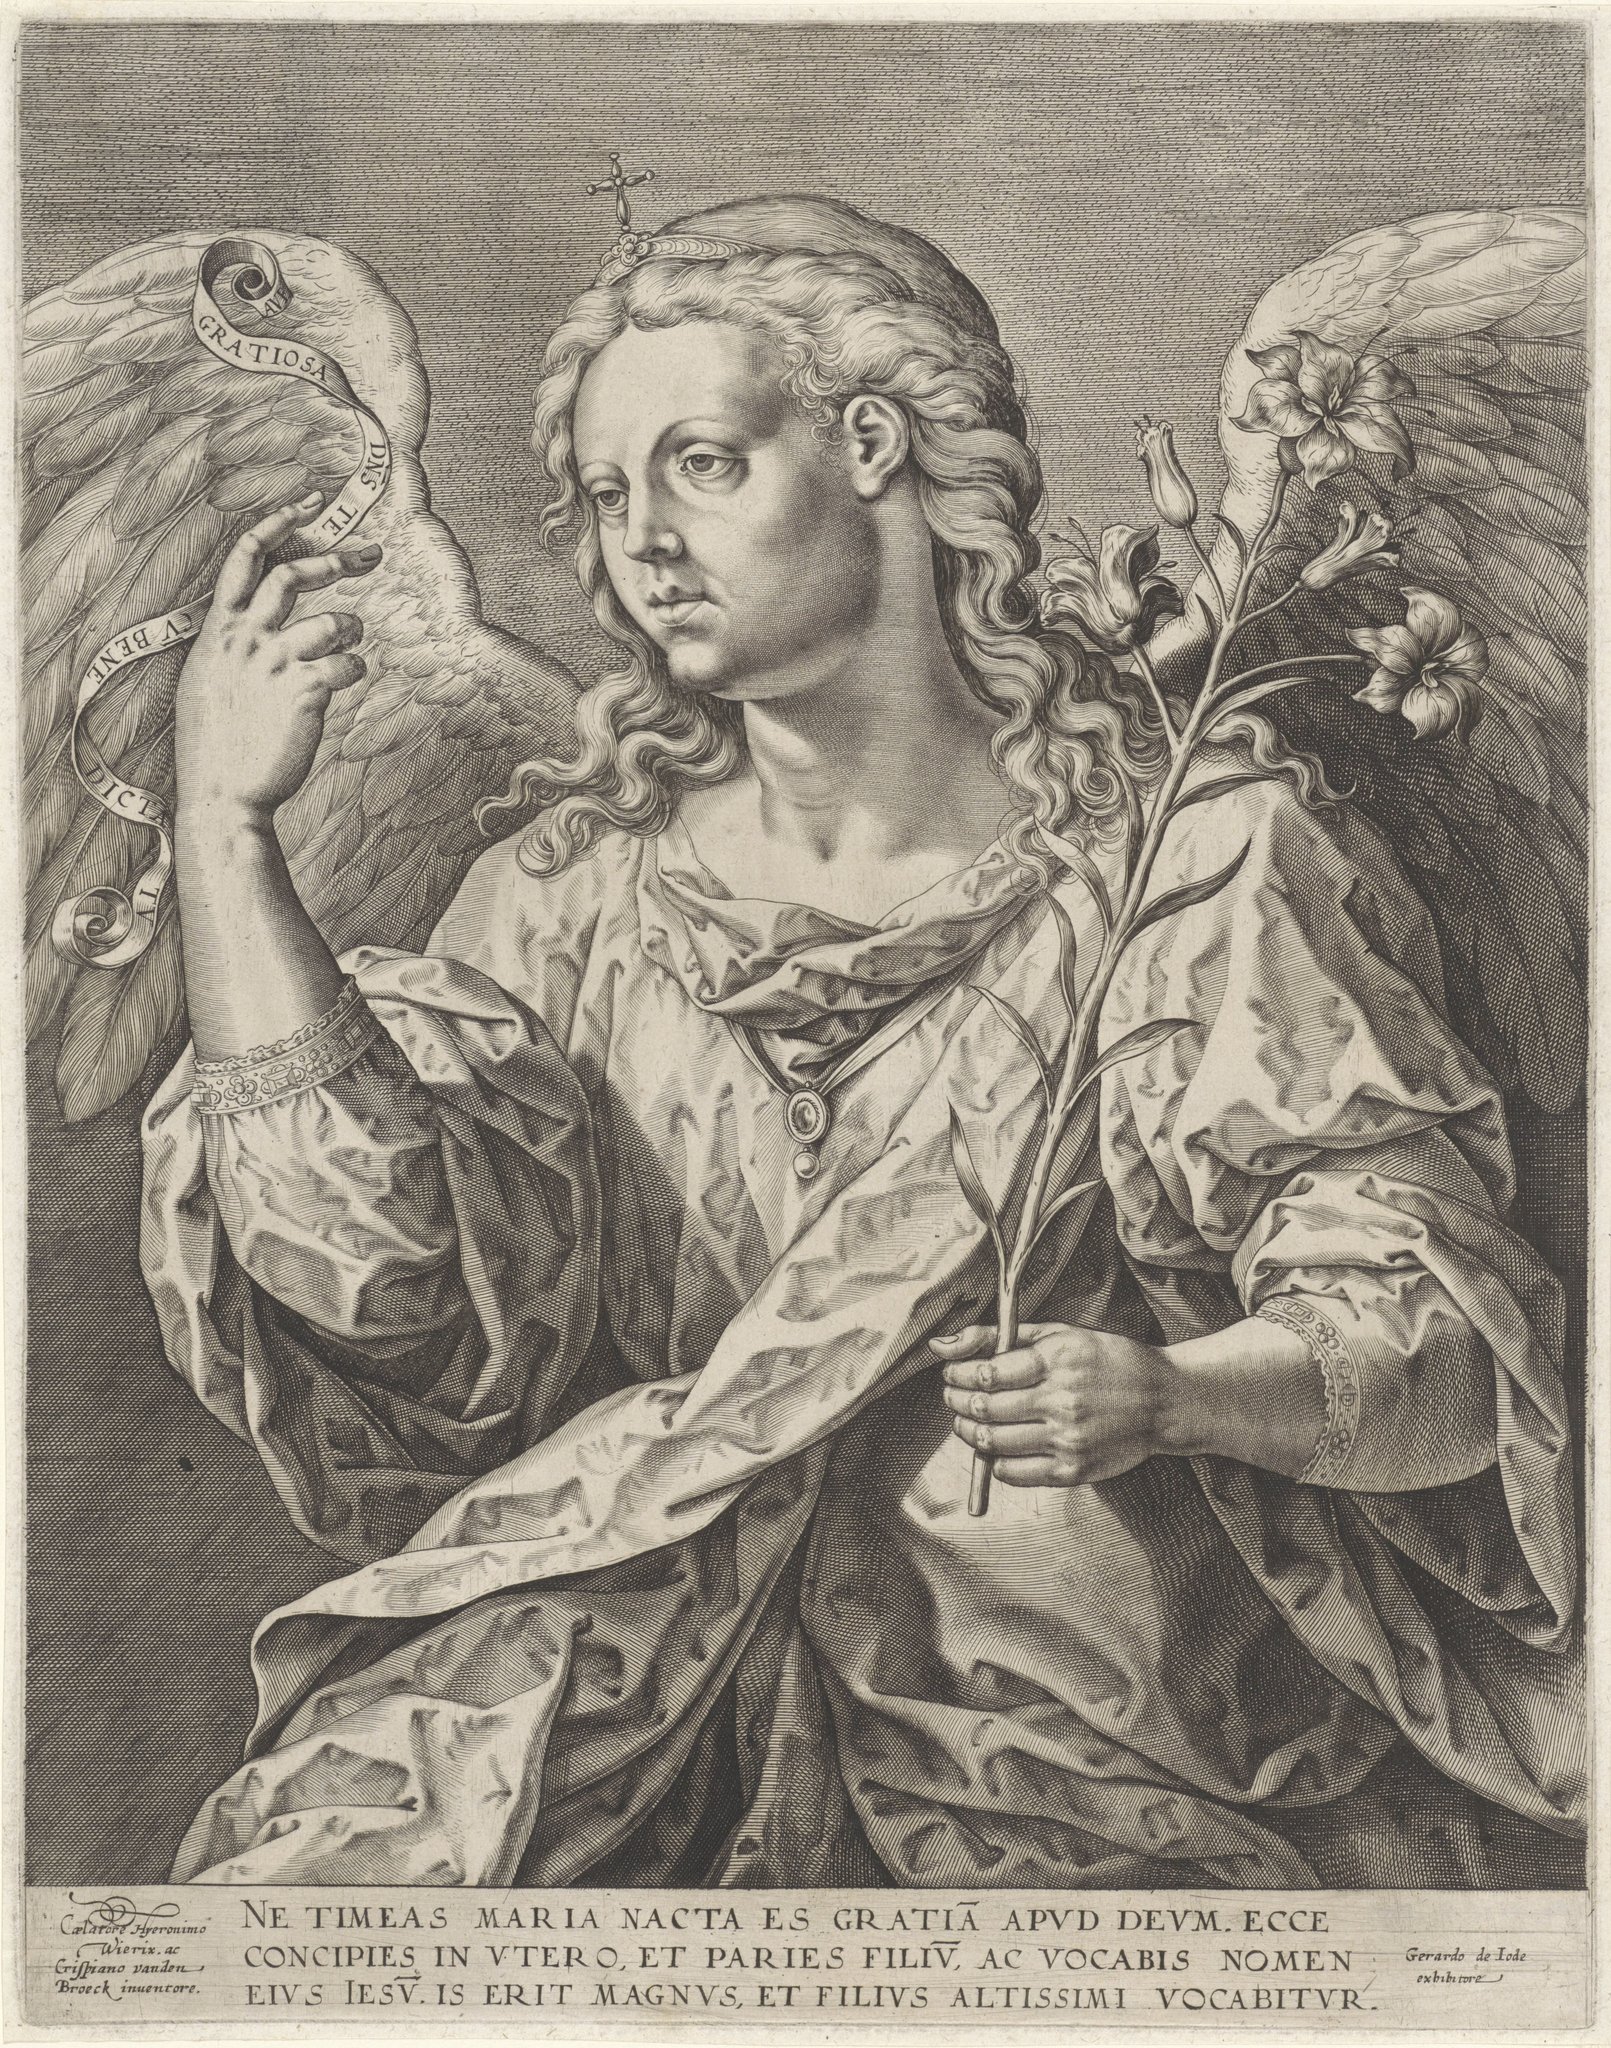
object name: print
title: Annunciatie (engel Gabriël)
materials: paper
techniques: engraving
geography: antwerp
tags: half-length figures of mary and the angel ~ annunciation, the announcement of christ's birth (luke 1:26-38)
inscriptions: collector's mark: Lugt 2542, collector's mark: Lugt 2233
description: De engel Gabriël maakt een spreekgebaar. In de handen houdt hij een lelie en een banderol met een opschrift in het Latijn.